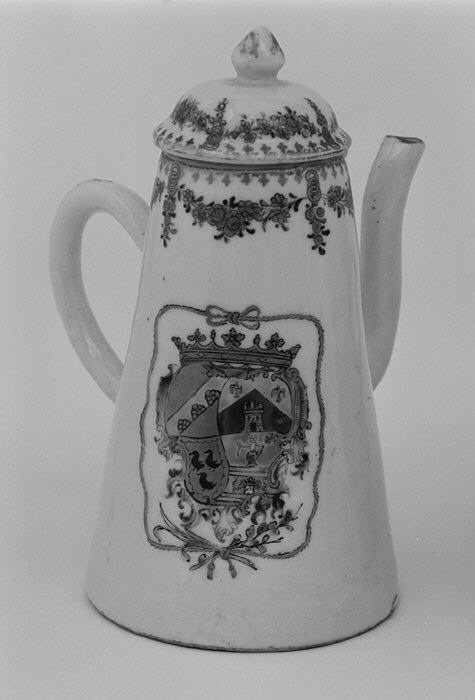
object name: coffeepot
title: Coffeepot (part of a service)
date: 1760-1770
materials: hard paste porcelain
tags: flowers,coat of arms